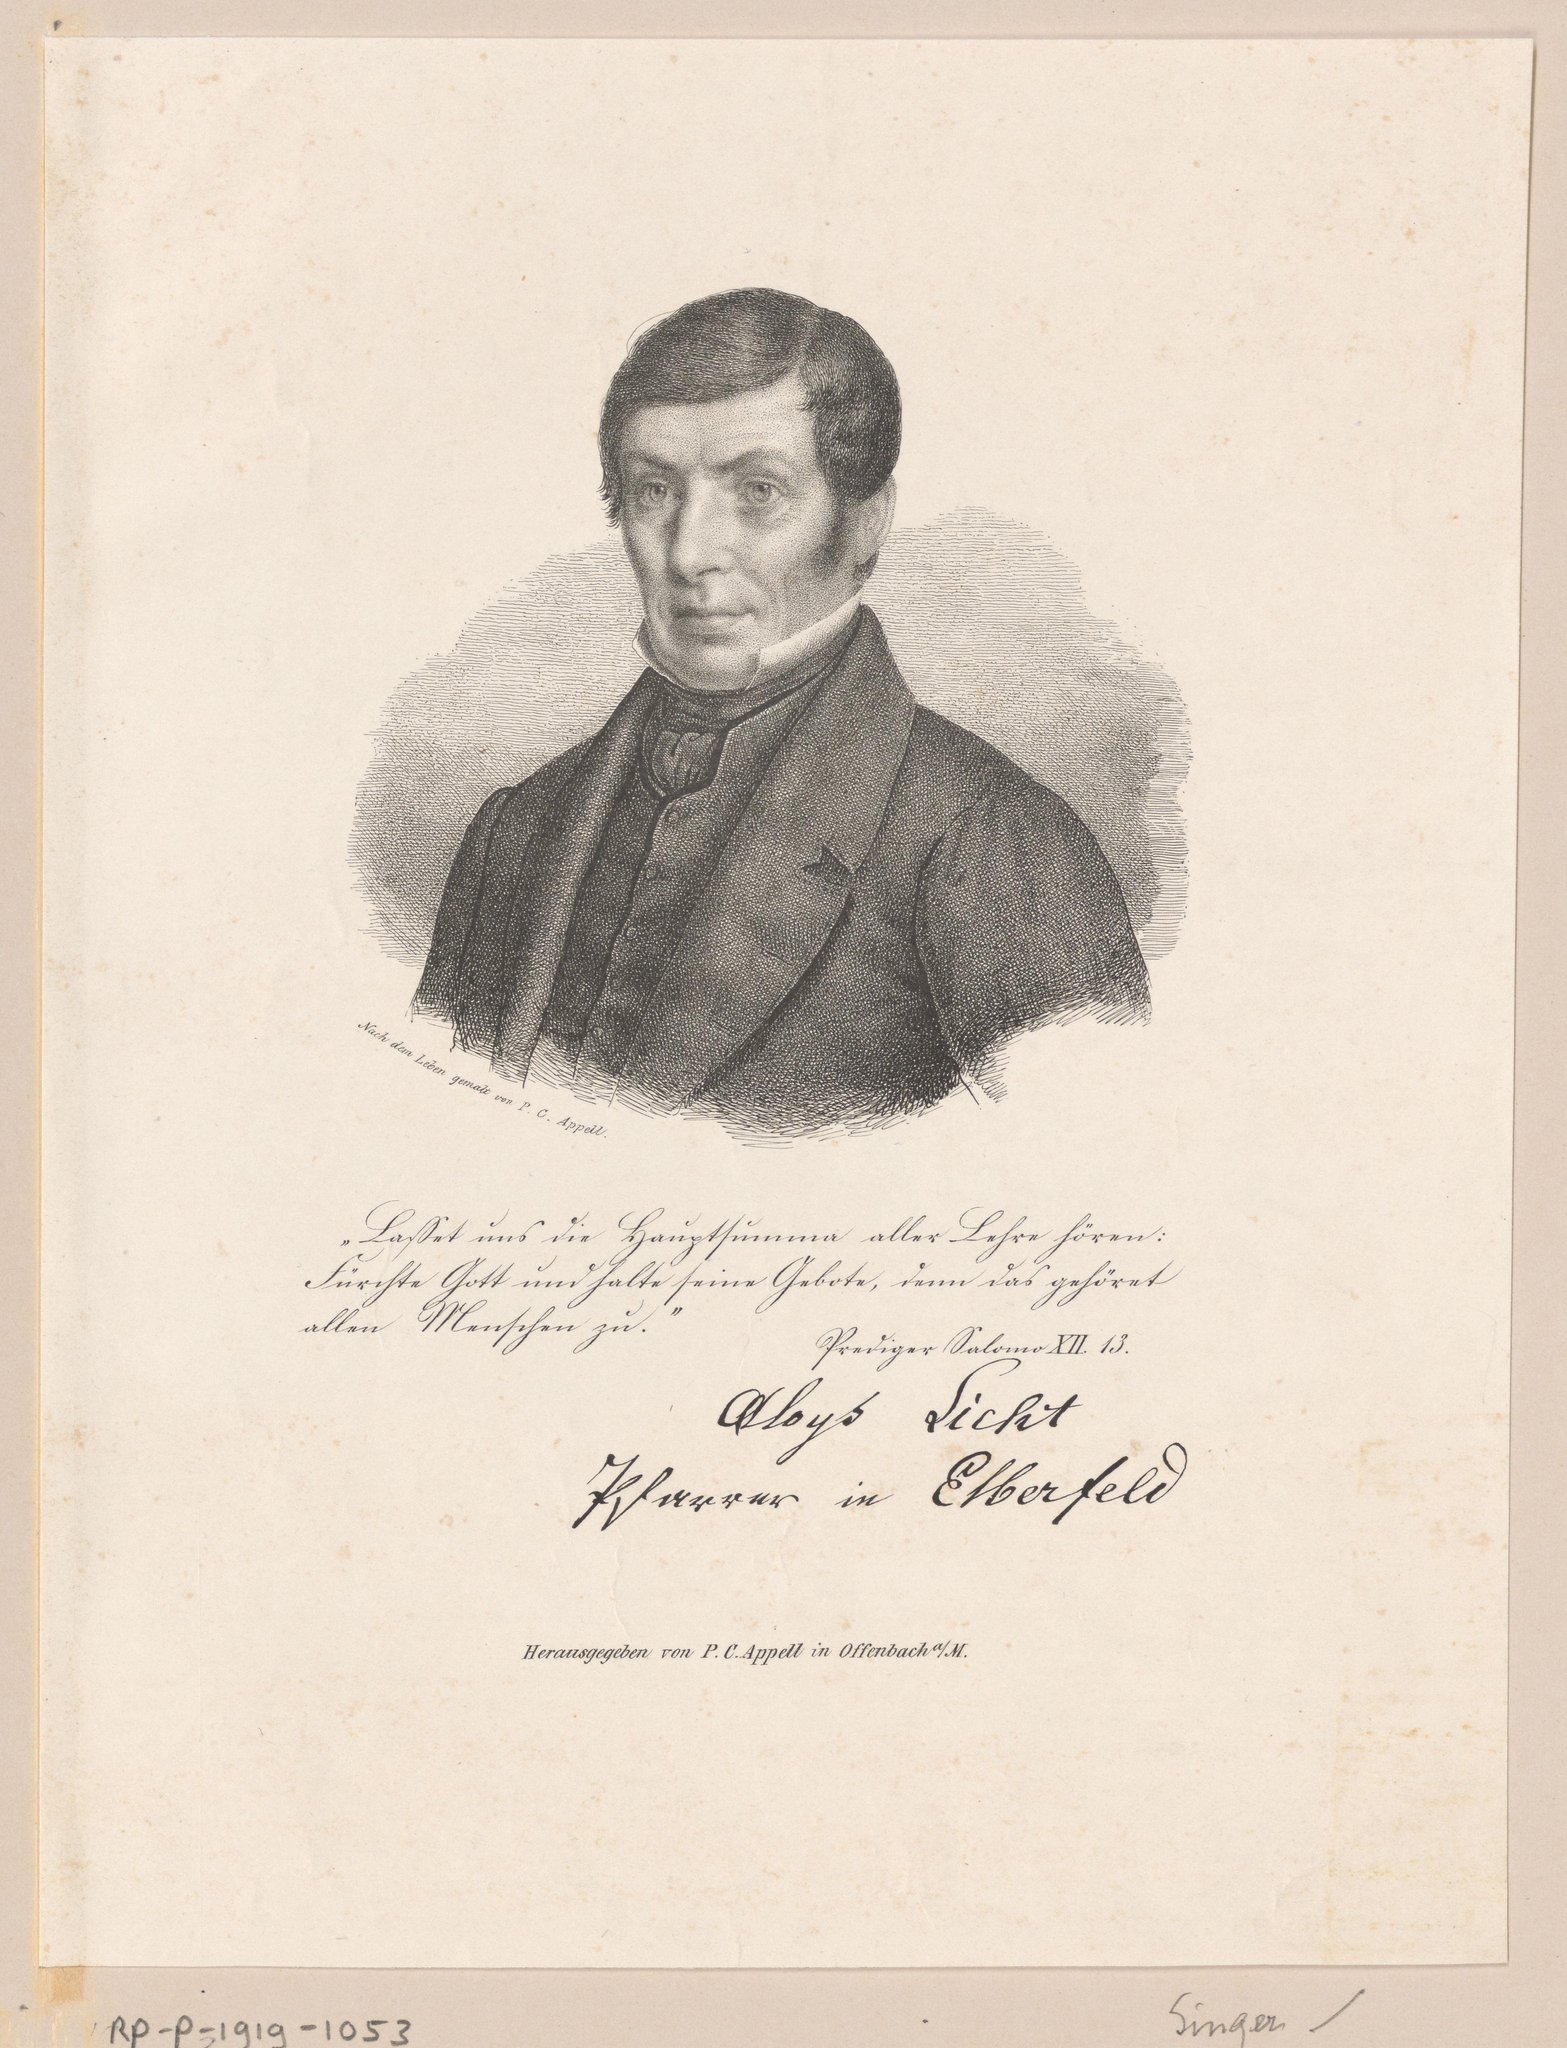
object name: print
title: Portret van Peter Alois Licht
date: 1820-1870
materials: paper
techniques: lithograph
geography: germany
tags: historical persons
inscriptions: collector's mark: Lugt 2228